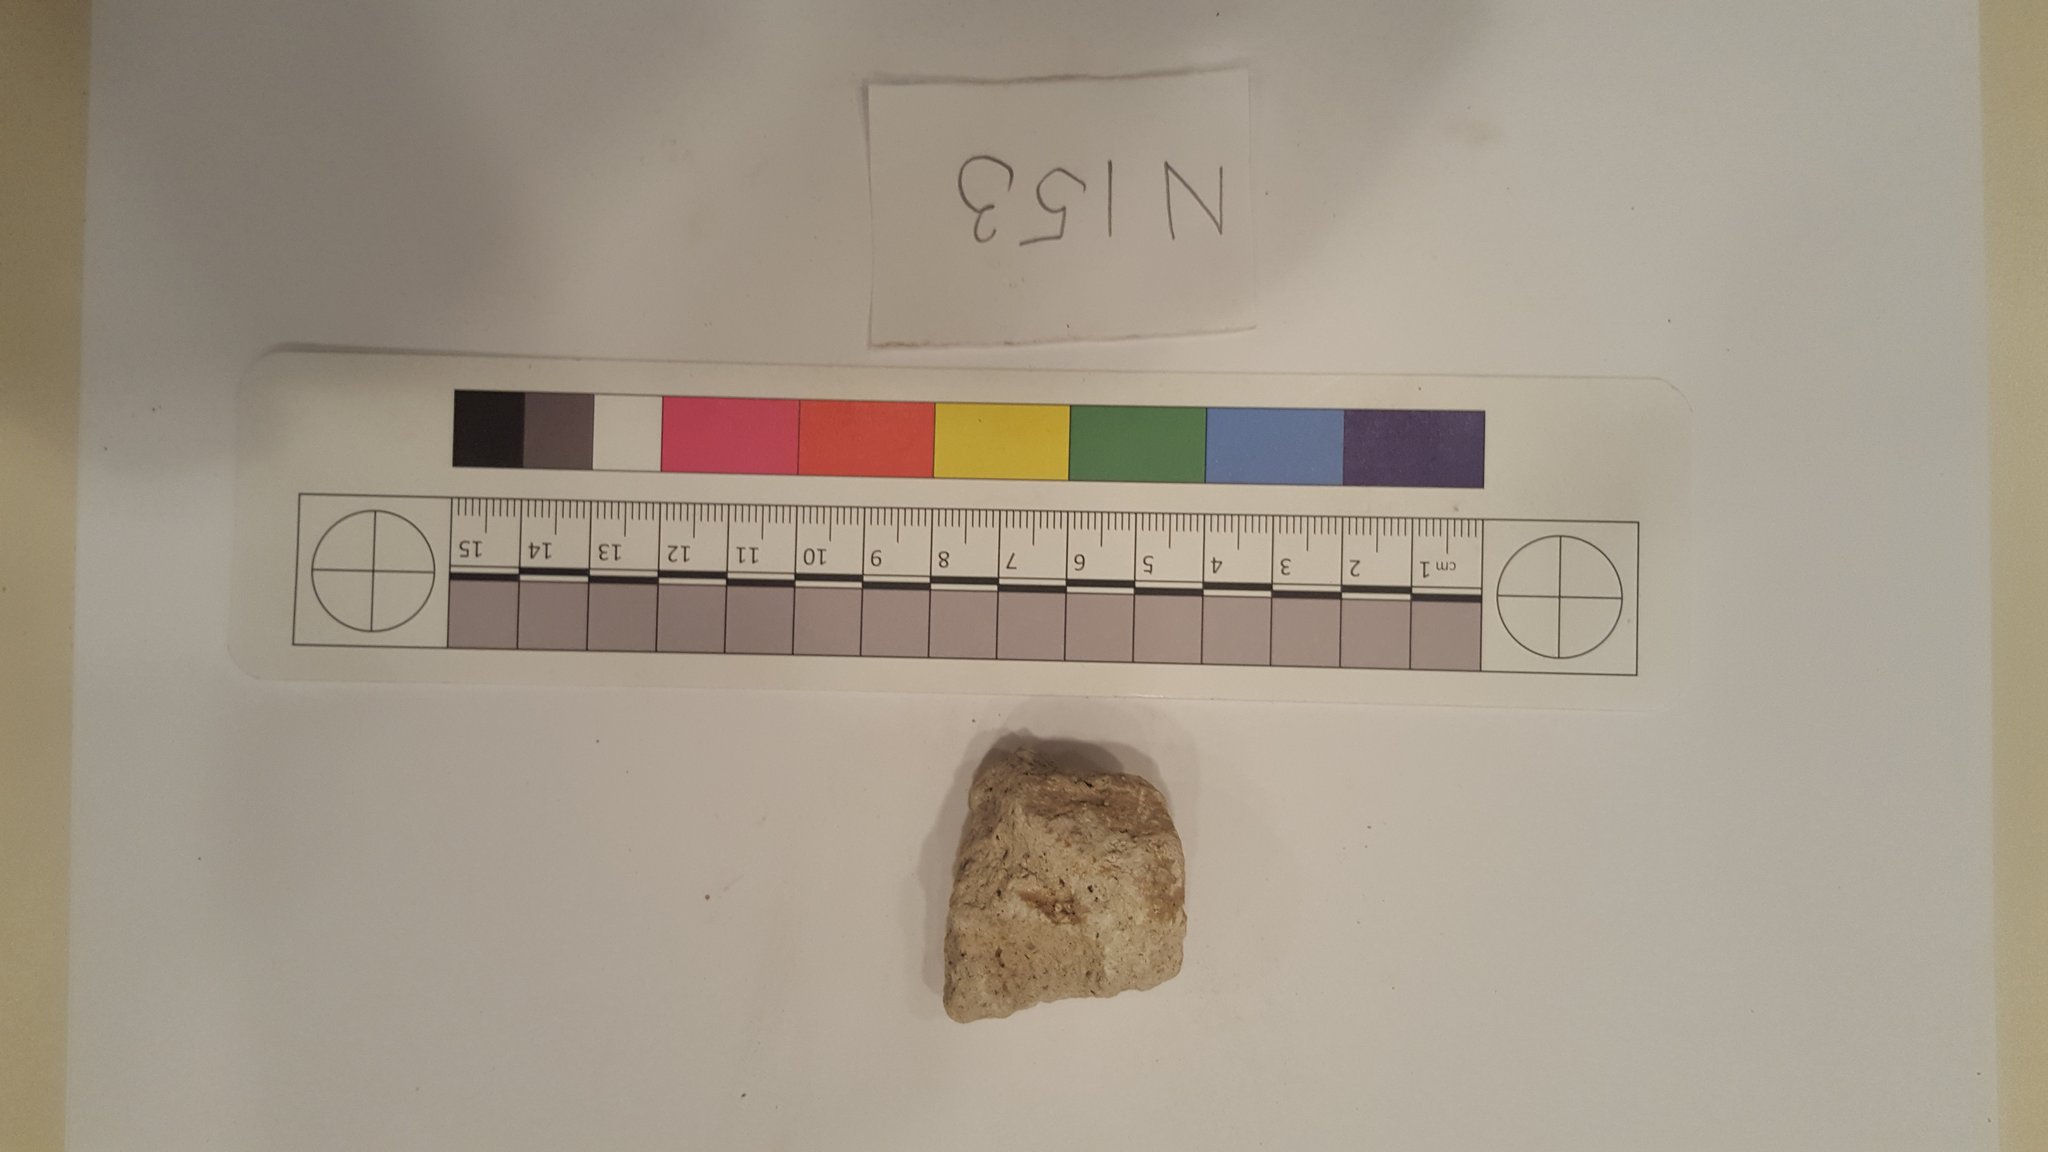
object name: fragment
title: Stucco Fragment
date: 701-1200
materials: plaster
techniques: carving, painting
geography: iran